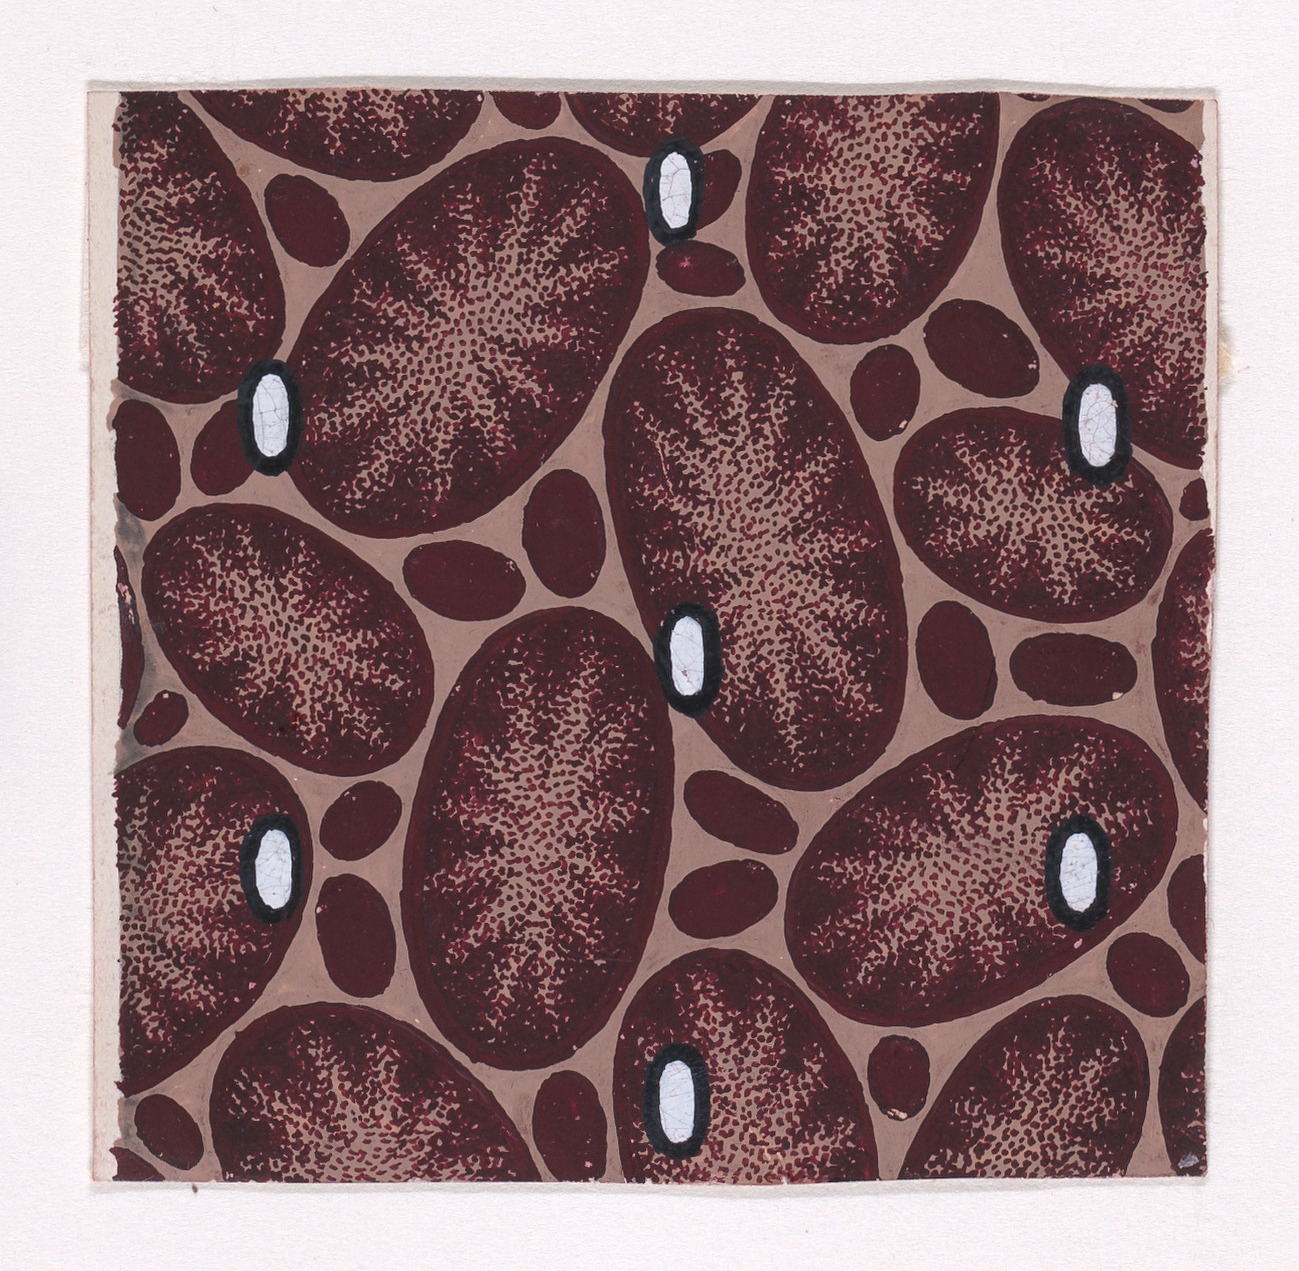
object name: drawing ornament architecture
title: Textile Design with Scattered Ovals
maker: anonymous, alsatian, 19th century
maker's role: artist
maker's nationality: alsatian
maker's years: 1800-1900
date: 1840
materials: gouache